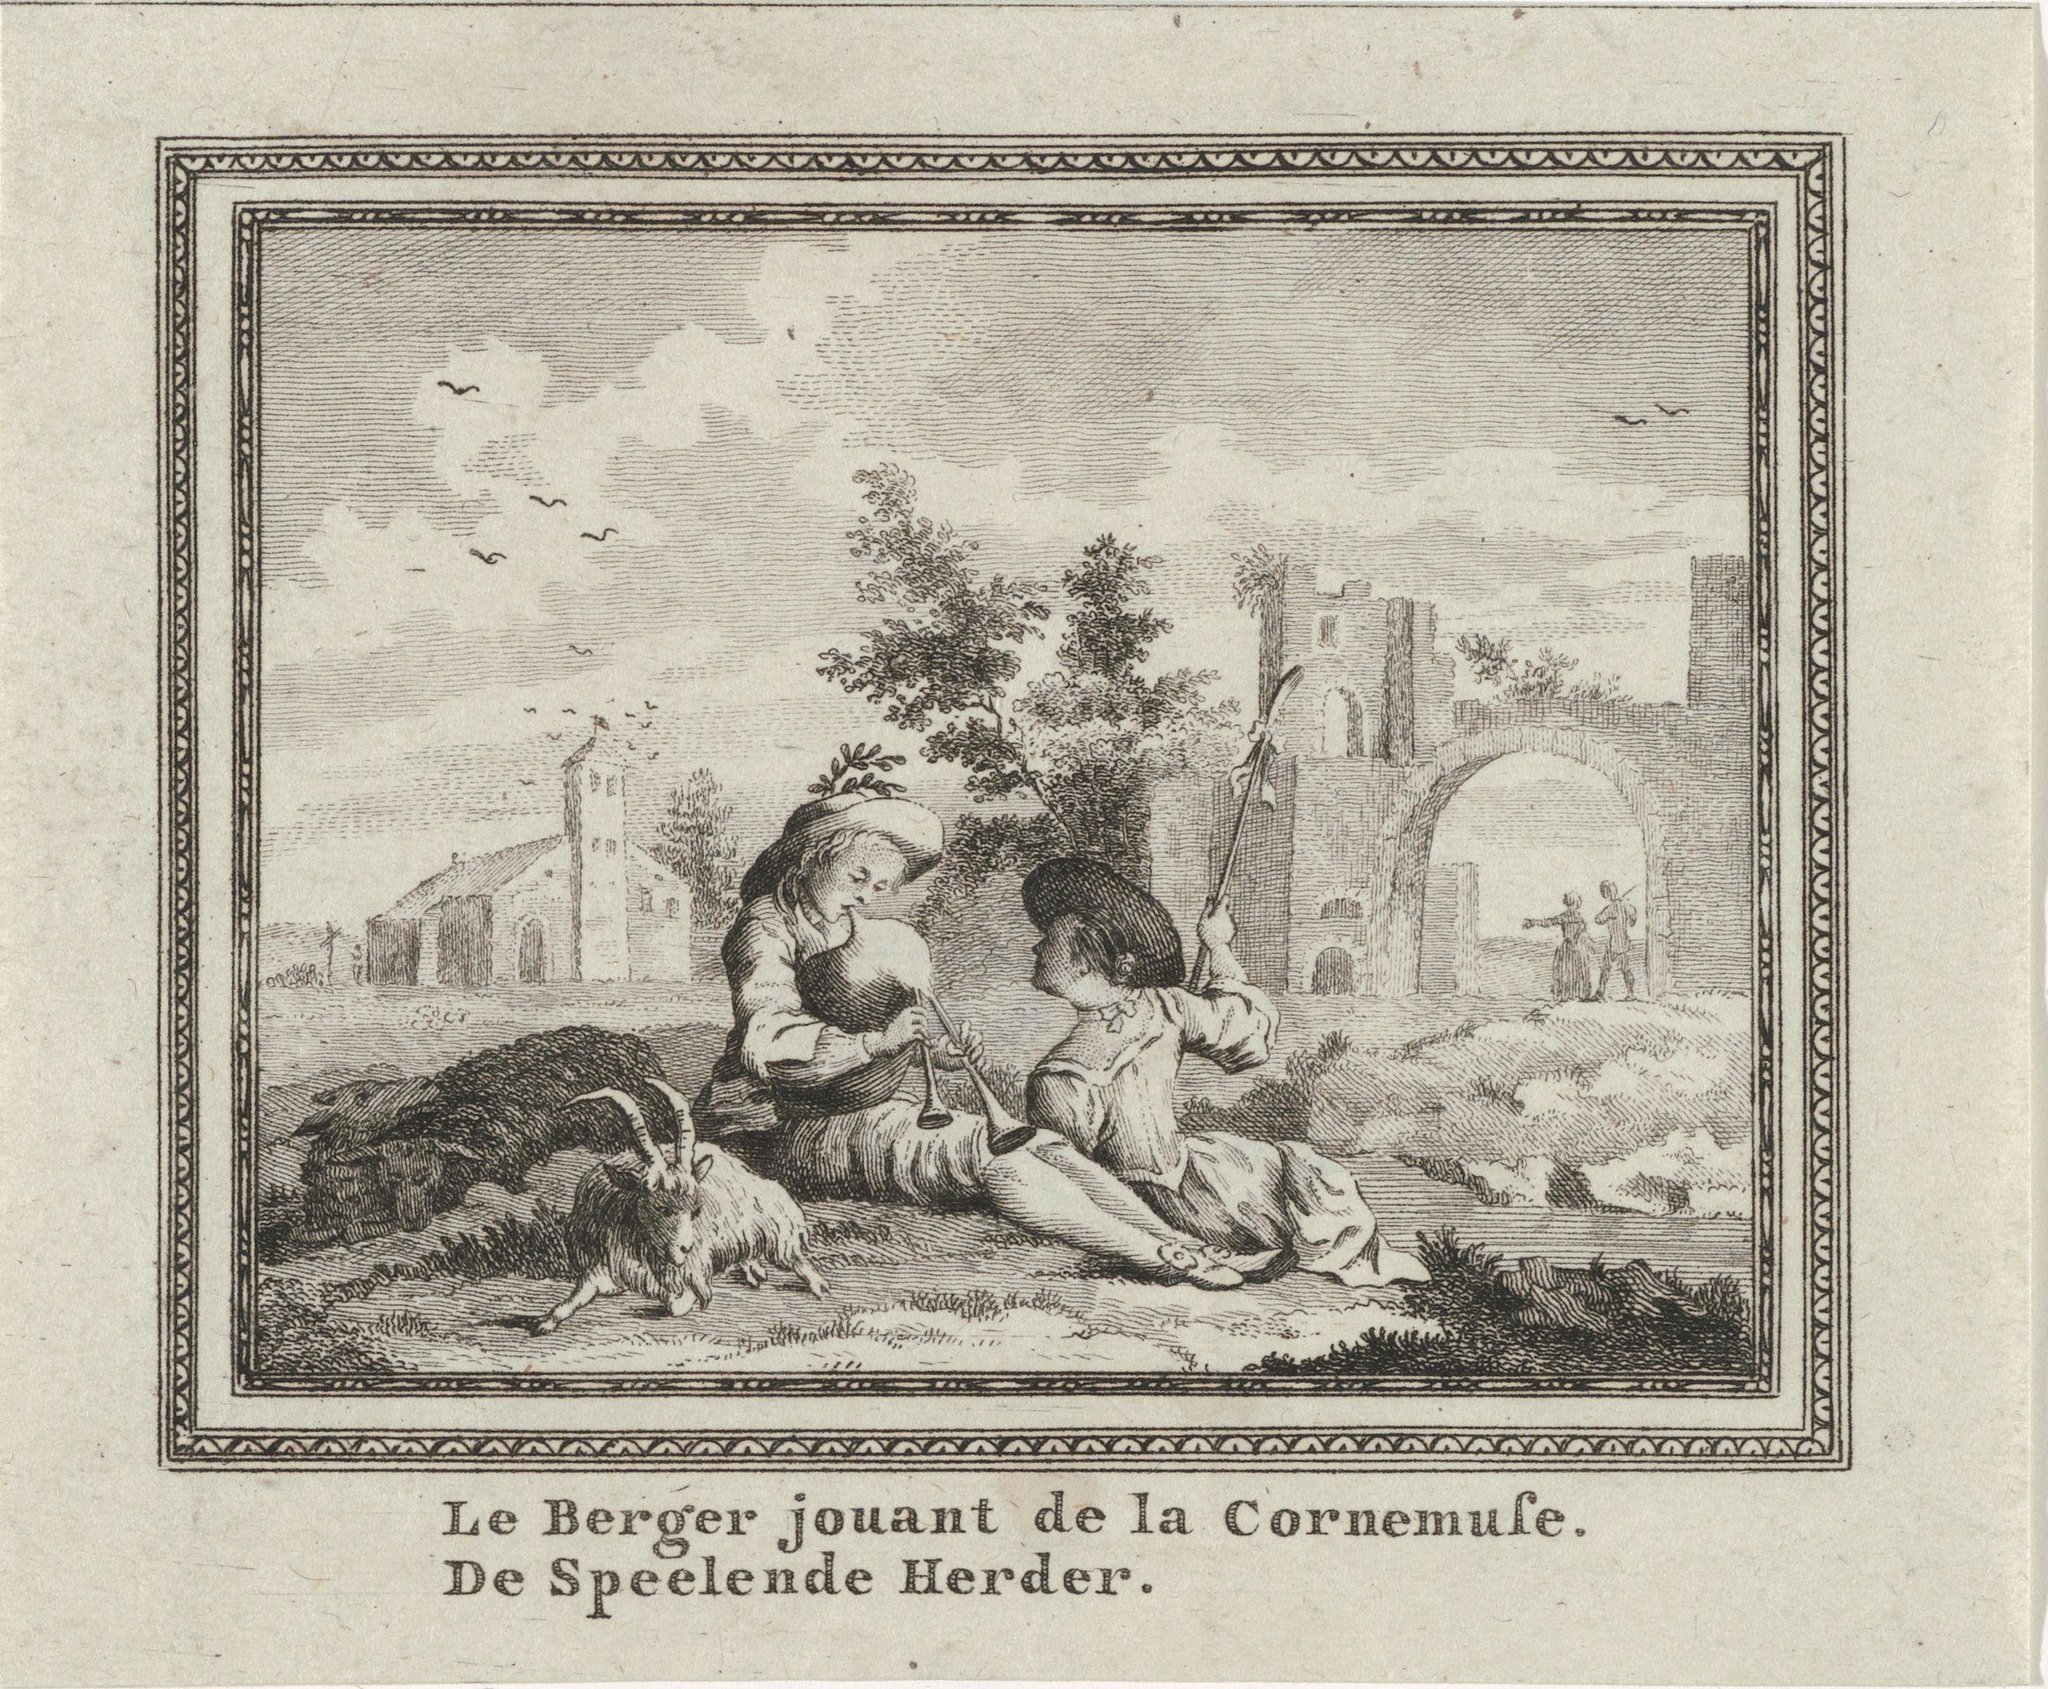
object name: print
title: Le berger jouant de la cornemuse / De speeldende herder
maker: Anonymous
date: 1750-1850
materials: paper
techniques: etching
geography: netherlands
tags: herding, herdsman, herdswoman, shepherd, shepherdess, cowherd, etc., bagpipe, musette - cc - out of doors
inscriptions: collector's mark: Lugt 2228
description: In een landschap bespeelt een herder de doedelzak. Een herderin luistert.